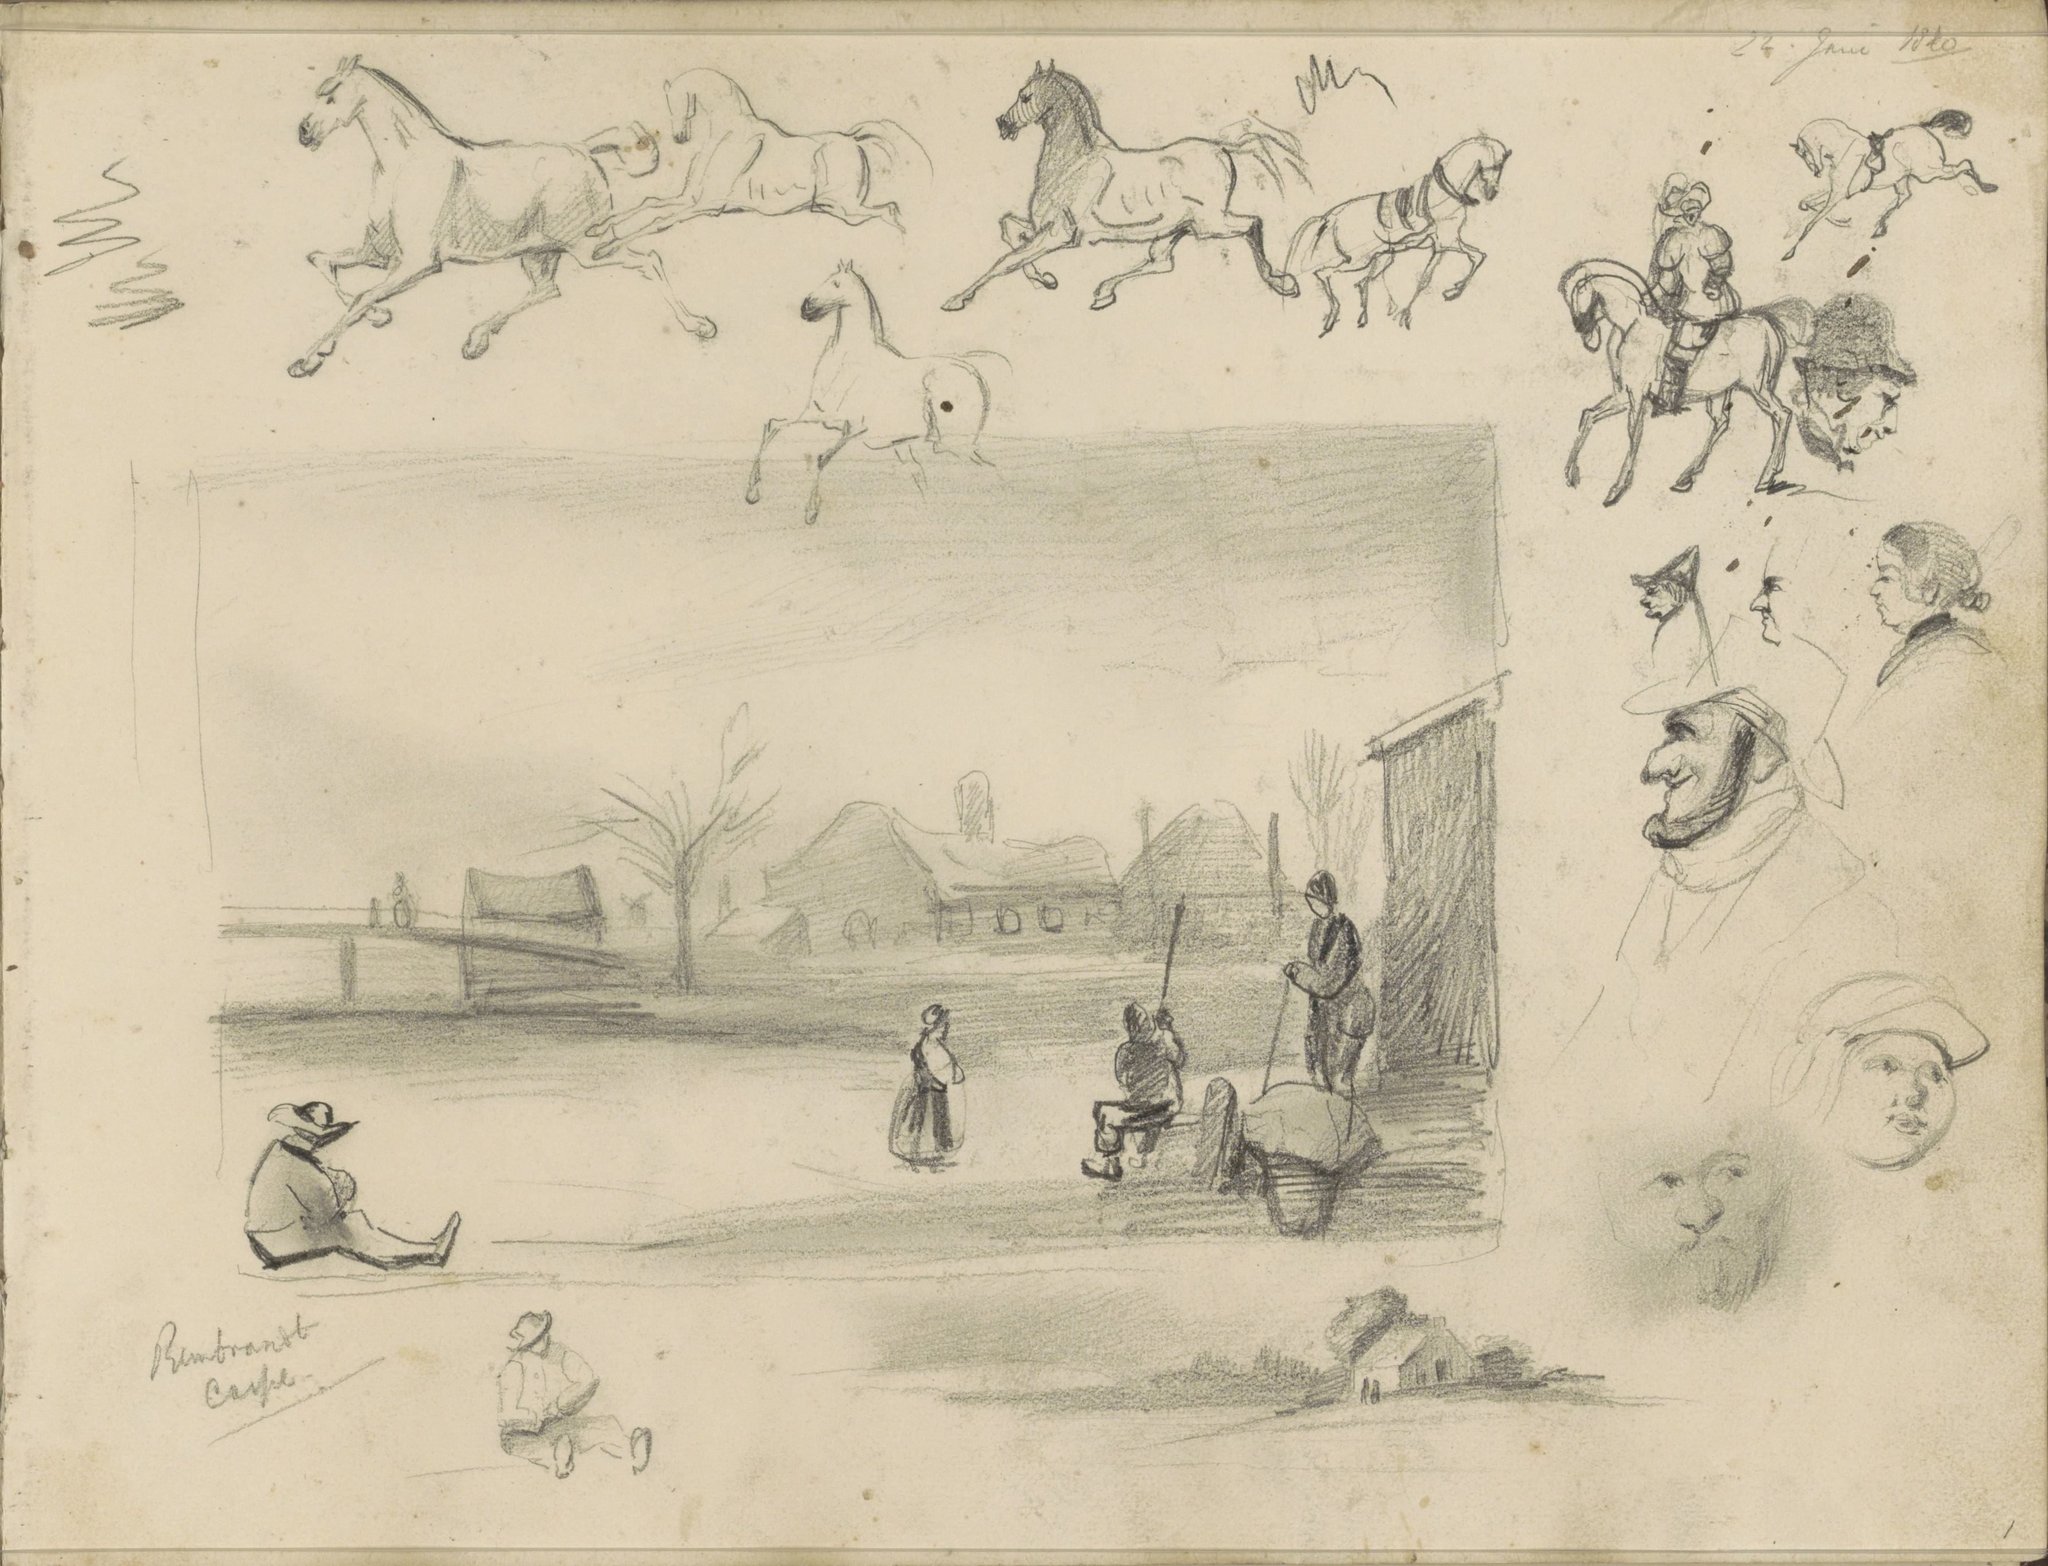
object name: sketchbook leaf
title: Paarden, karikaturale koppen en een winterlandschap naar Rembrandt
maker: johannes tavenraat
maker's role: draughtsman, painter, print maker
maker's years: 1809-1881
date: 1806-1840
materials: paper, pencil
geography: kassel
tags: head (human), horse, landscapes (+ landscape with figures, staffage)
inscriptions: annotation: ‘Rembrandt/ Kassel.’, date: ‘22 Juni 1840.’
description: Het winterlandschap van Rembrandt uit 1646 bevindt zich in het museum van Kassel.